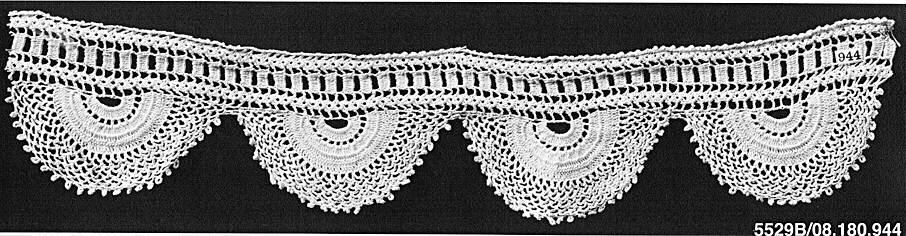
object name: crochet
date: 1801-1900